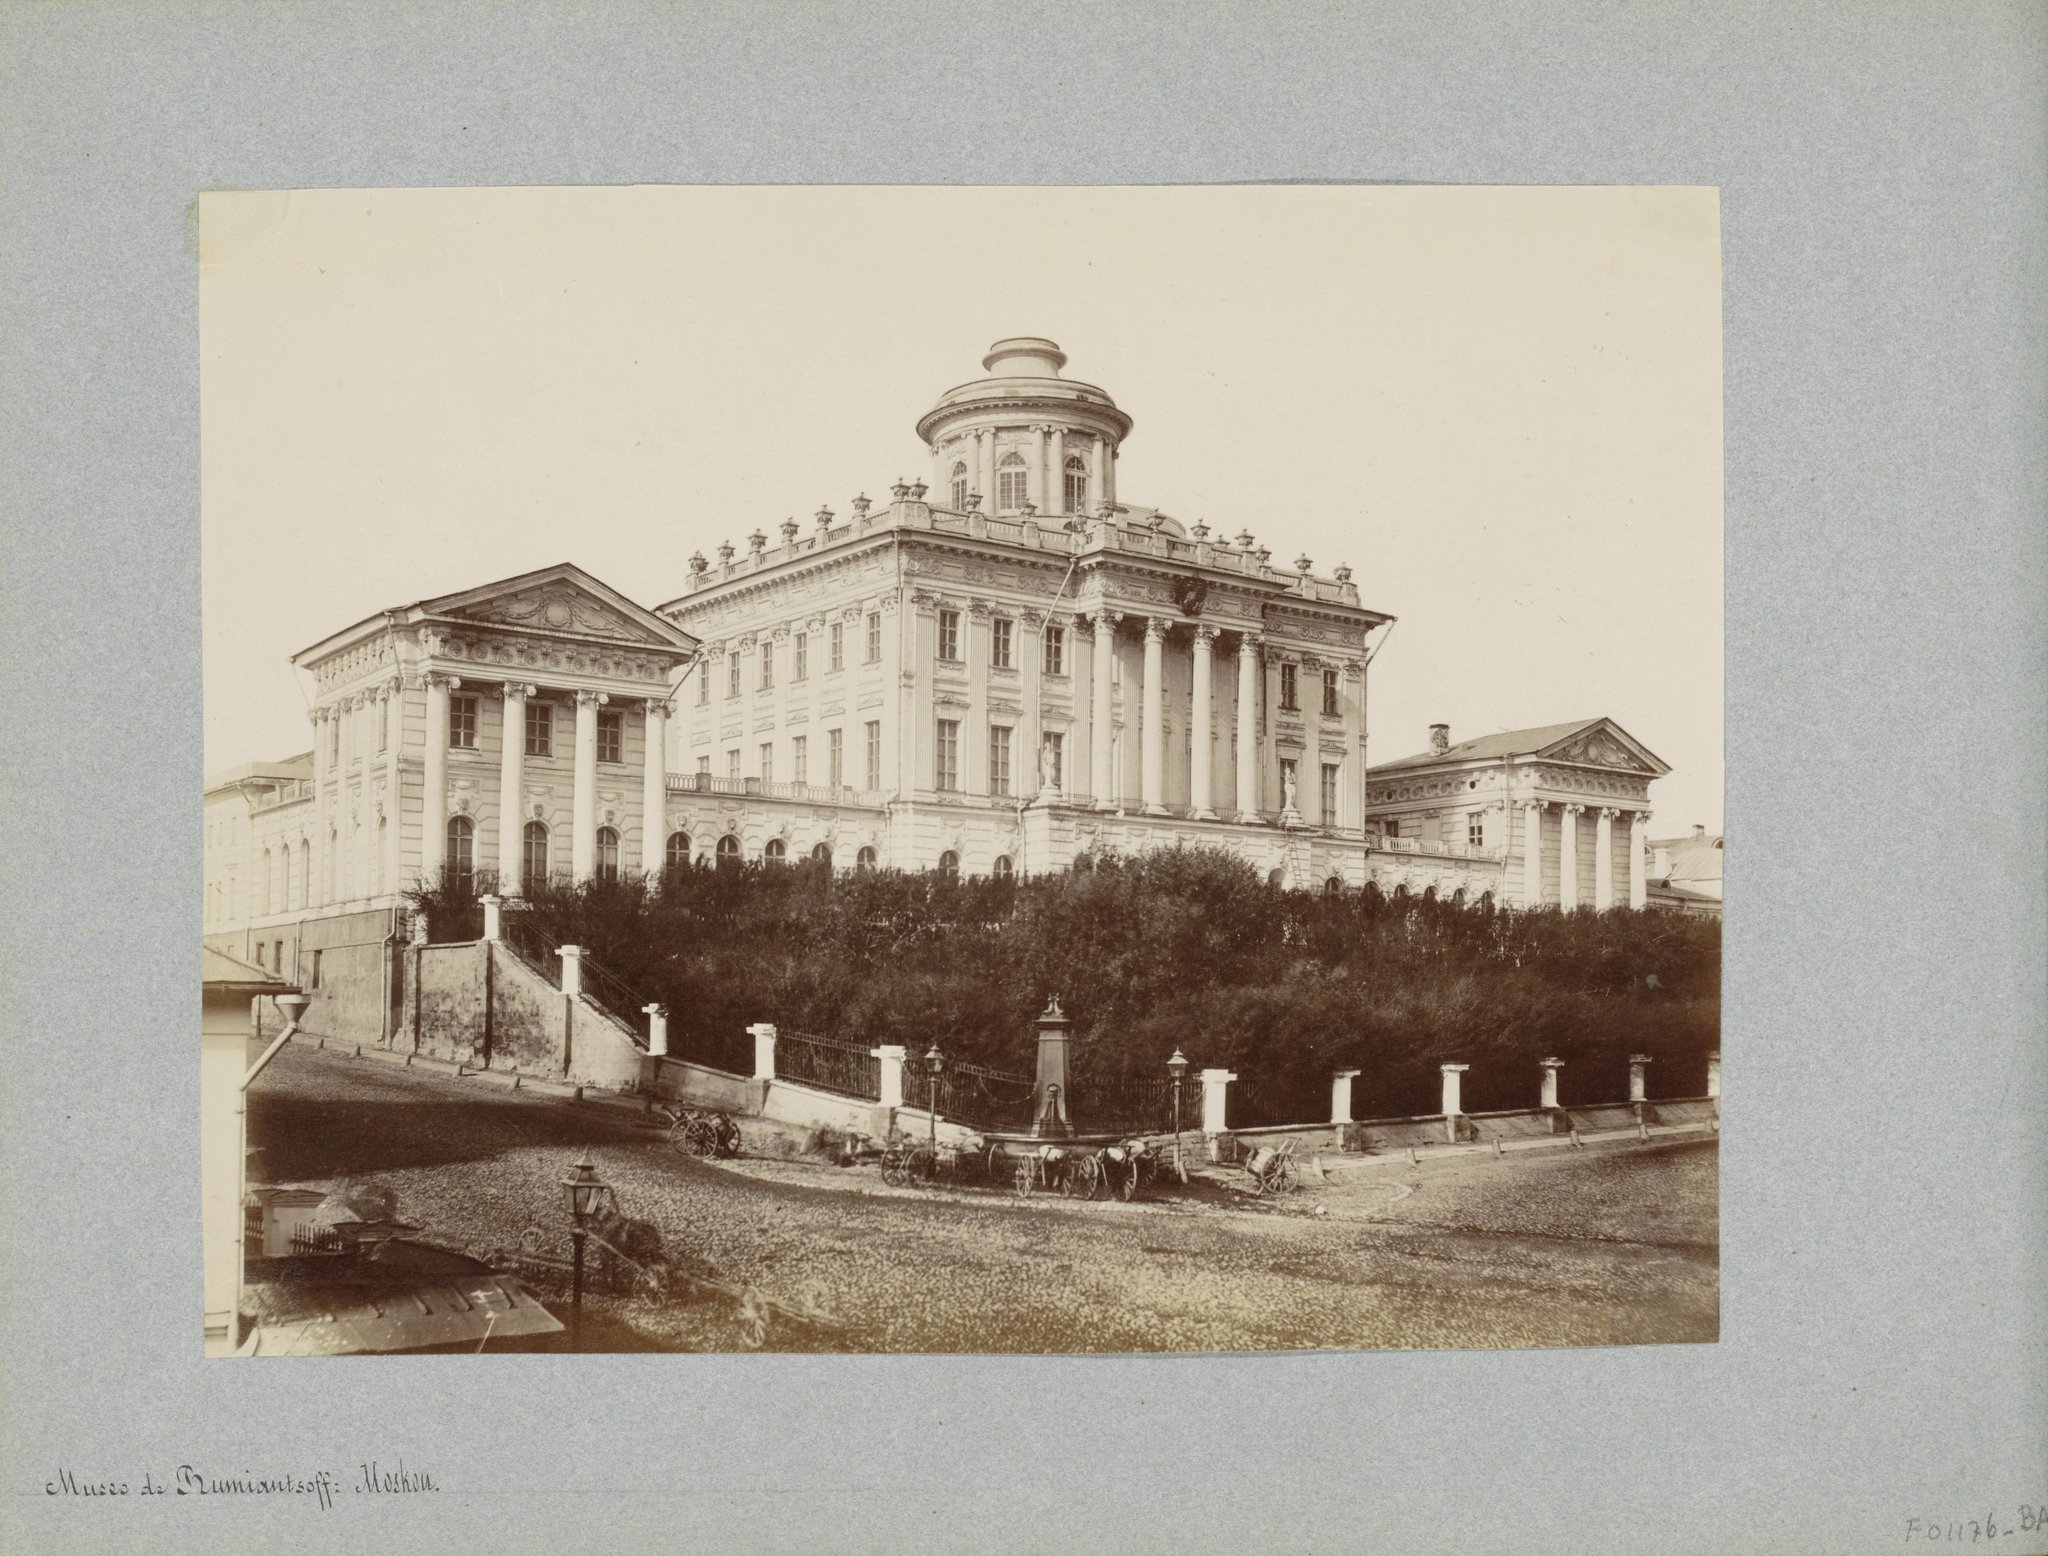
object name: photograph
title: Exterieur van het Roumiantzoff Museum in Moskou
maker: Anonymous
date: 1850-1876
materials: photographic support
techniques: albumen print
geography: moscow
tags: travelling; tourism, exterior ~ representation of a building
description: Onderdeel van Reisalbum met foto's en tekeningen van Manuel Mayo 1876.